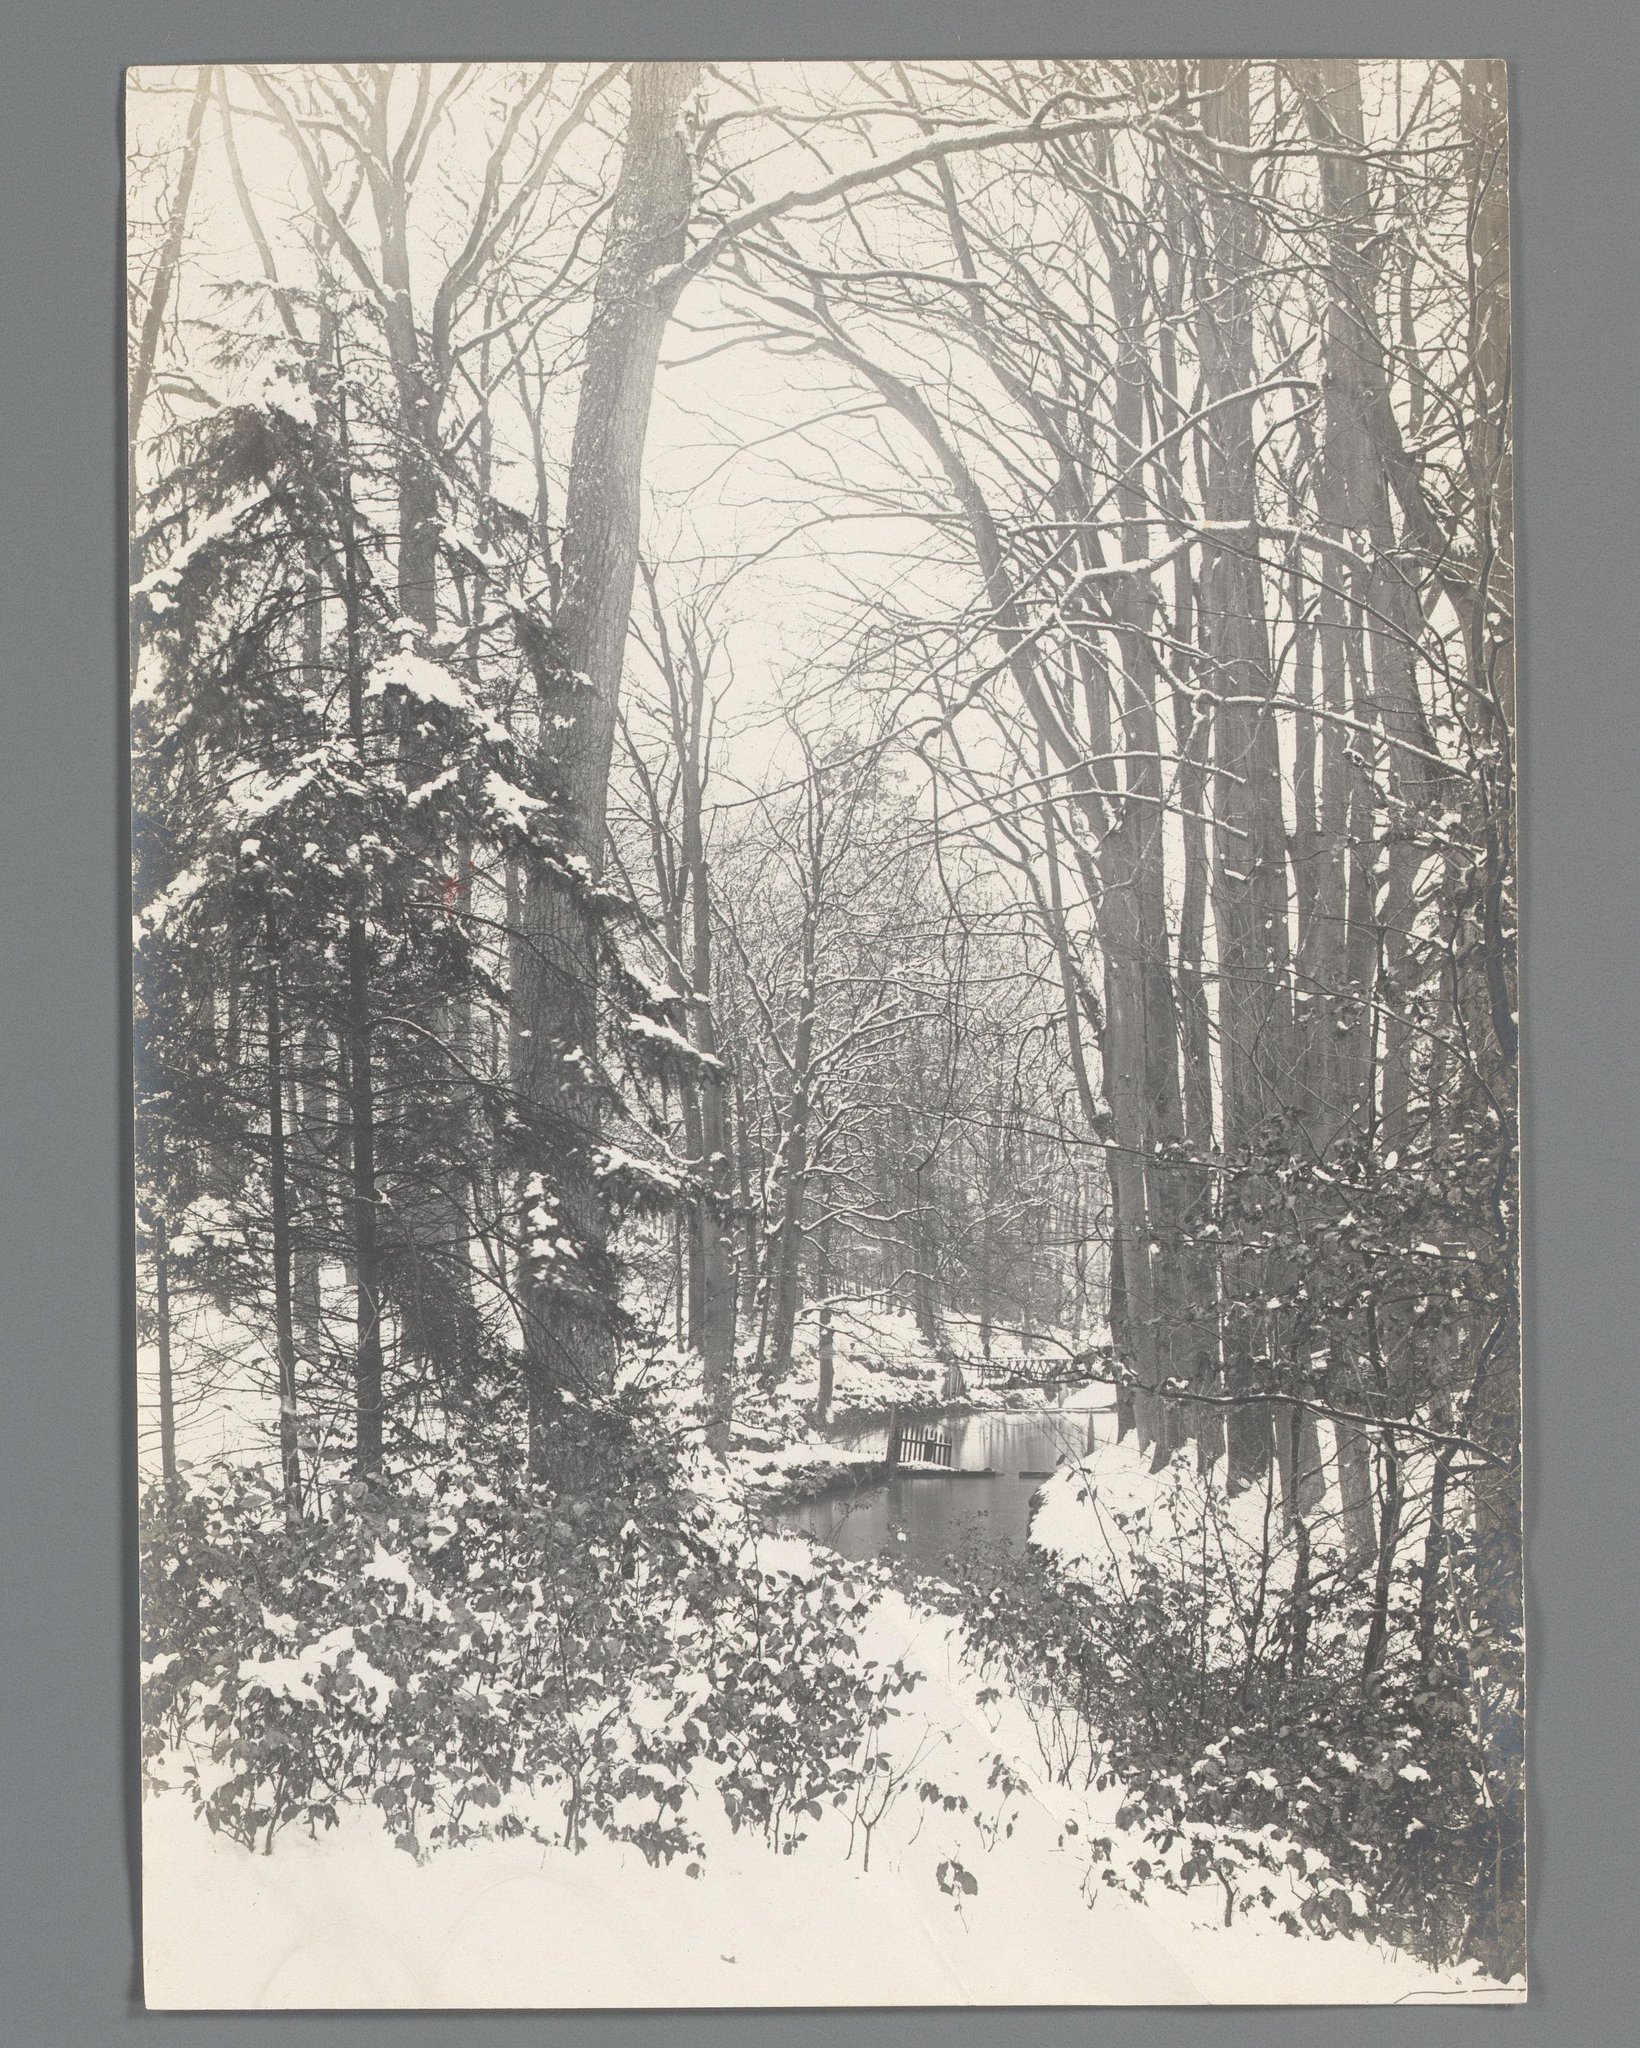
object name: photograph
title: Besneeuwd boslandschap met beek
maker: willem de jong (fotograaf)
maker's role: arts, fotograaf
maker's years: 1864-1918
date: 1895-1918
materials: paper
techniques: gelatin silver print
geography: netherlands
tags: forest, wood, brook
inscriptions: inscription: ‘foto Willem de Jong’